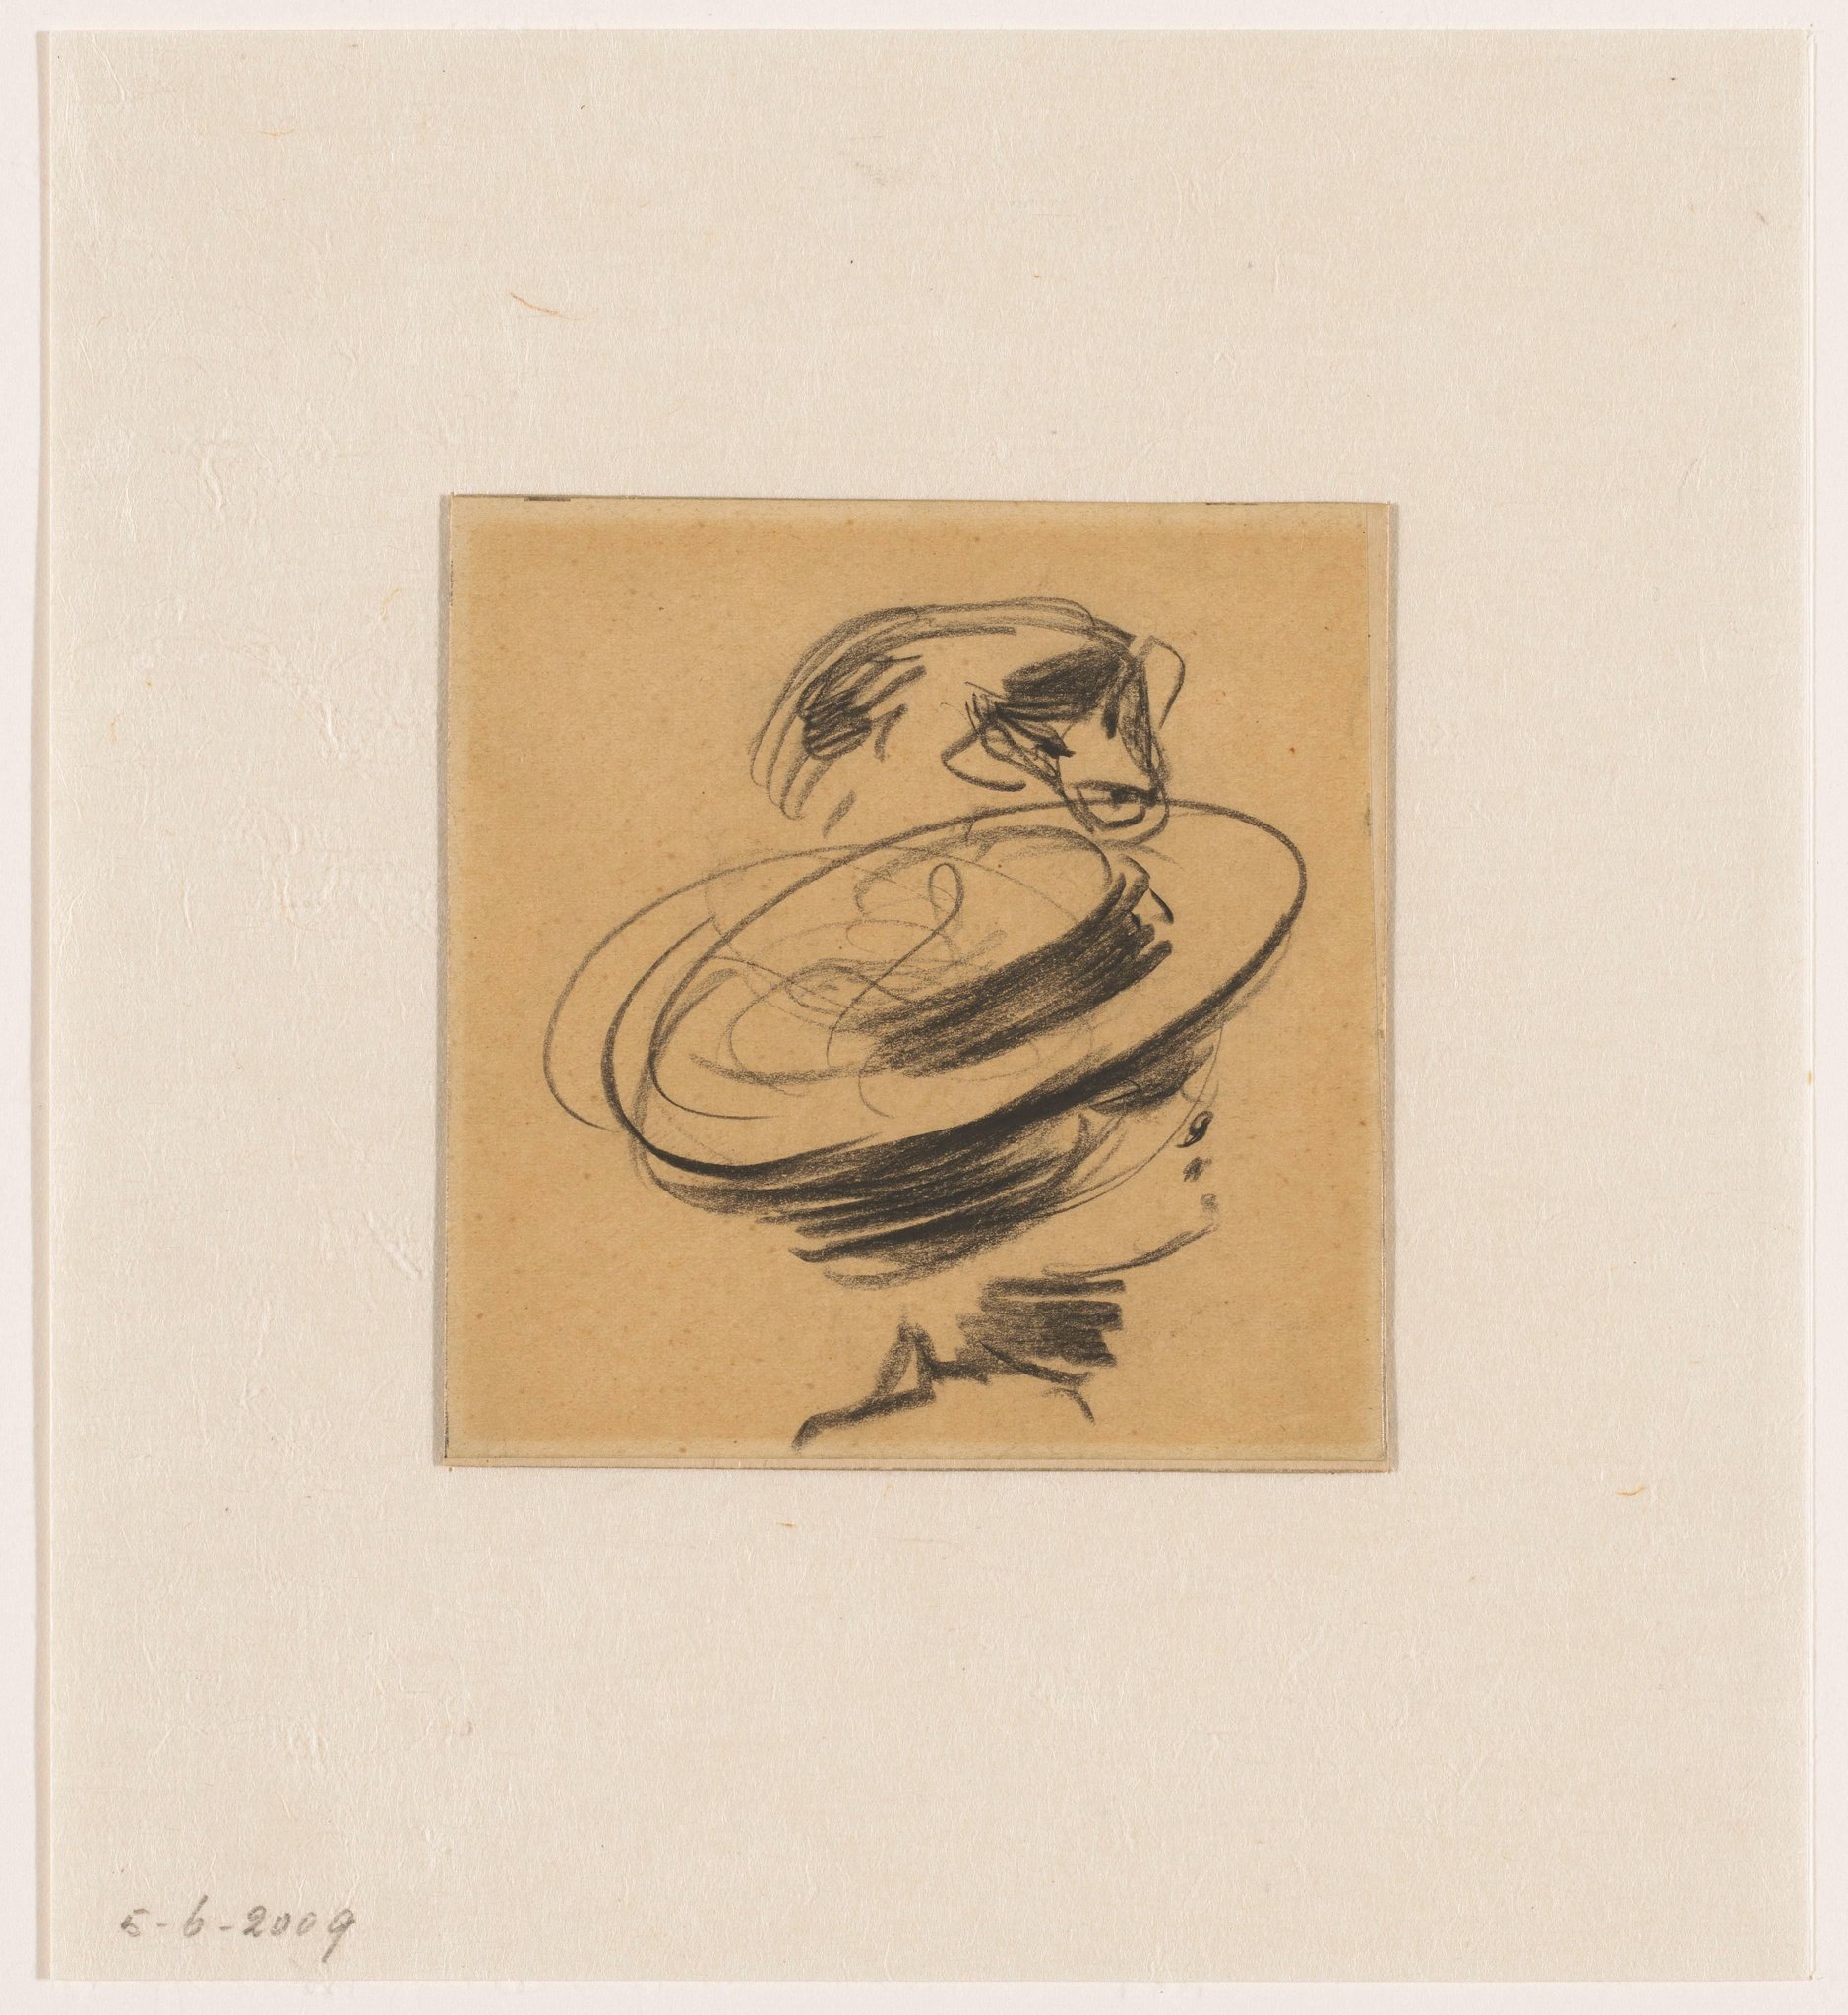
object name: drawing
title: Portret van een vrouw met een modieuze hoed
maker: carel nicolaas storm van s-gravesande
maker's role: draughtsman, print maker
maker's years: 1841-1924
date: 1905-1909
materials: chalk, paper